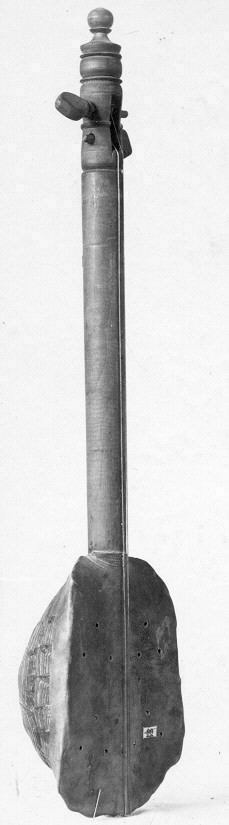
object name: guenbri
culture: algerian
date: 1867-1900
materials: shell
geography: algeria